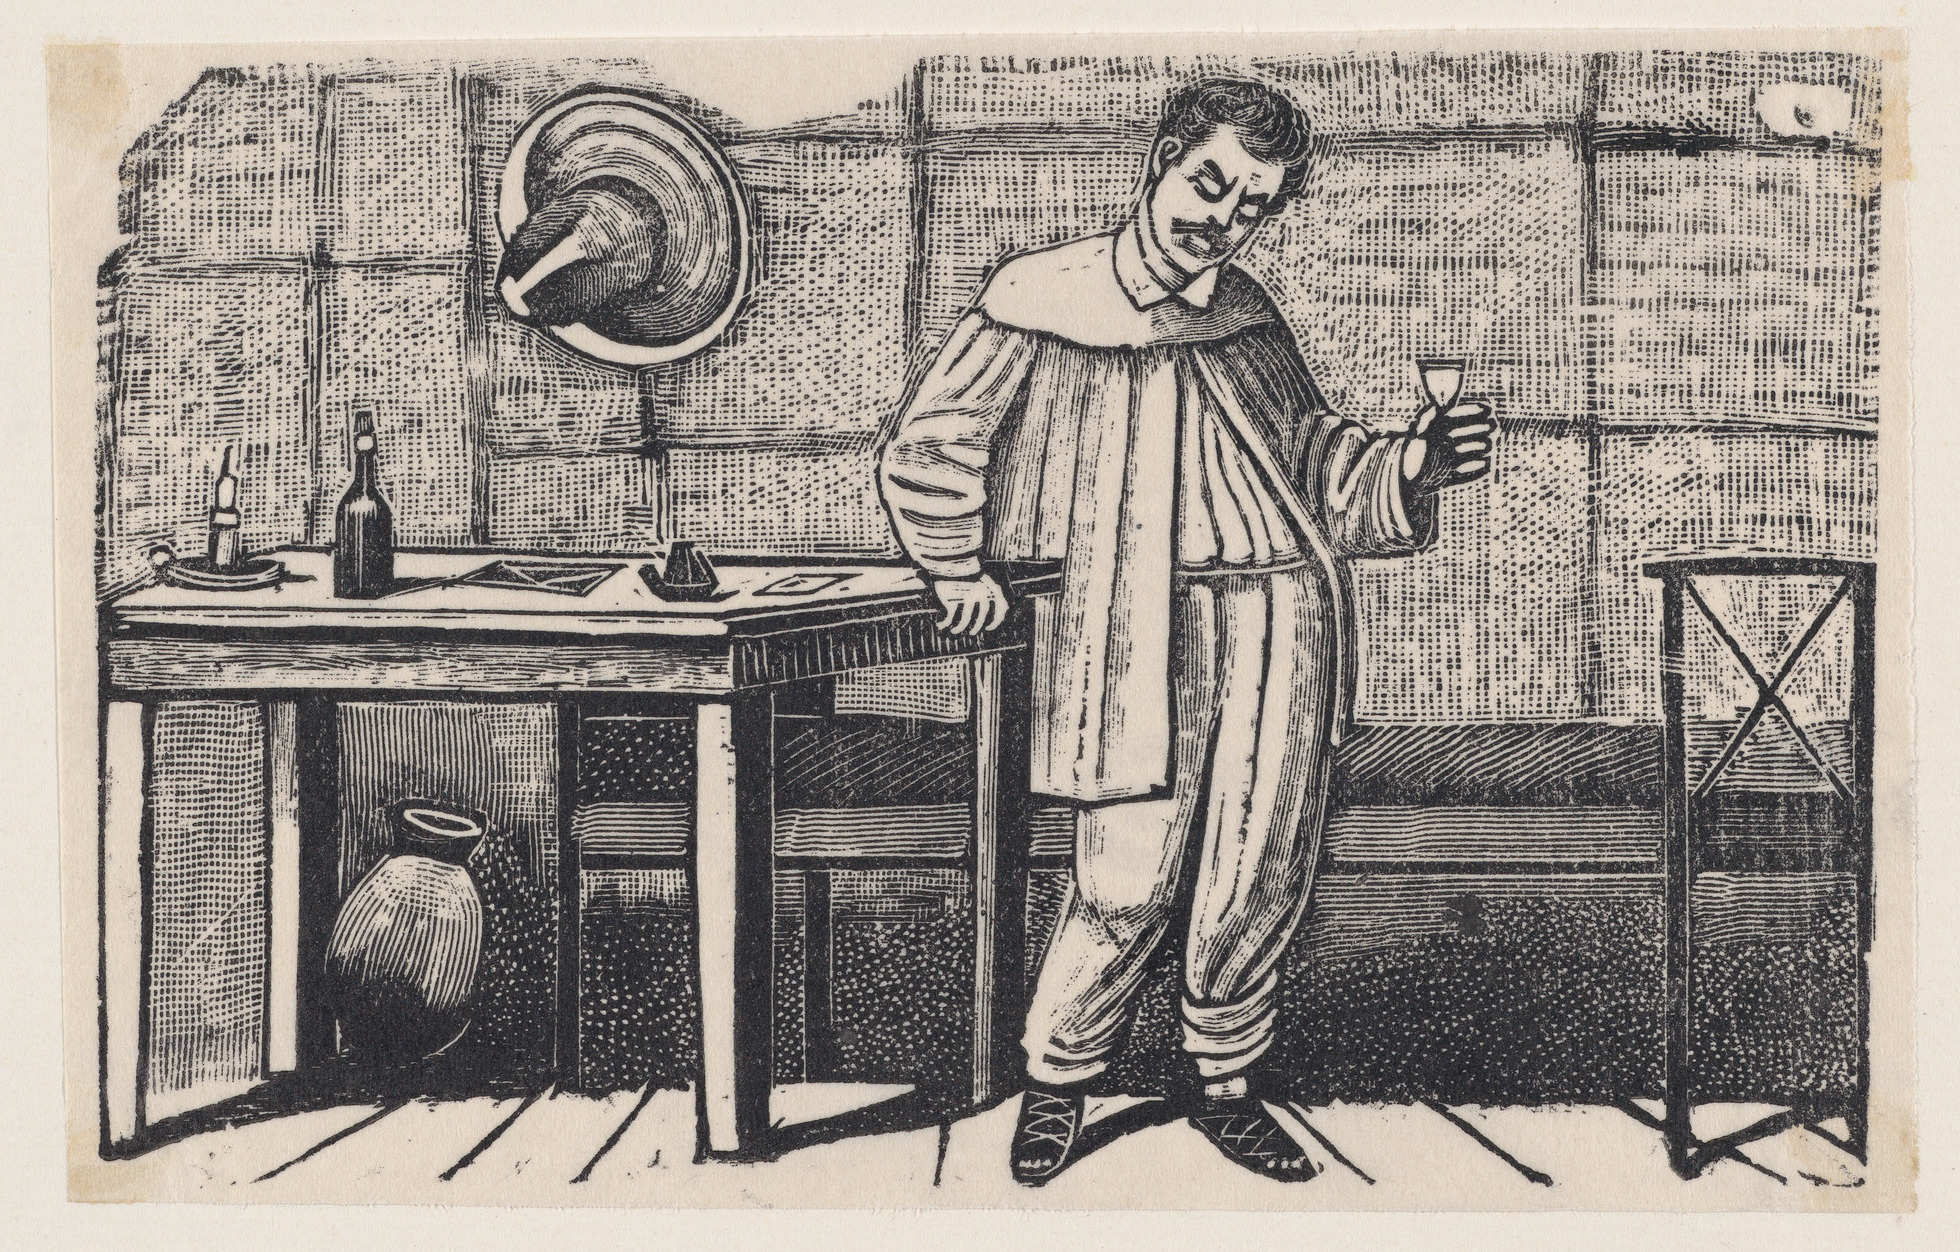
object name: print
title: A man with a glass in his hand looking downwards and leaning on a table, an illustration from 'El huérfano'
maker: josé guadalupe posada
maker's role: artist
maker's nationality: mexican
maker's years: 1852-1913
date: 1880-1910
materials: metal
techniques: engraving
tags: men,drinking